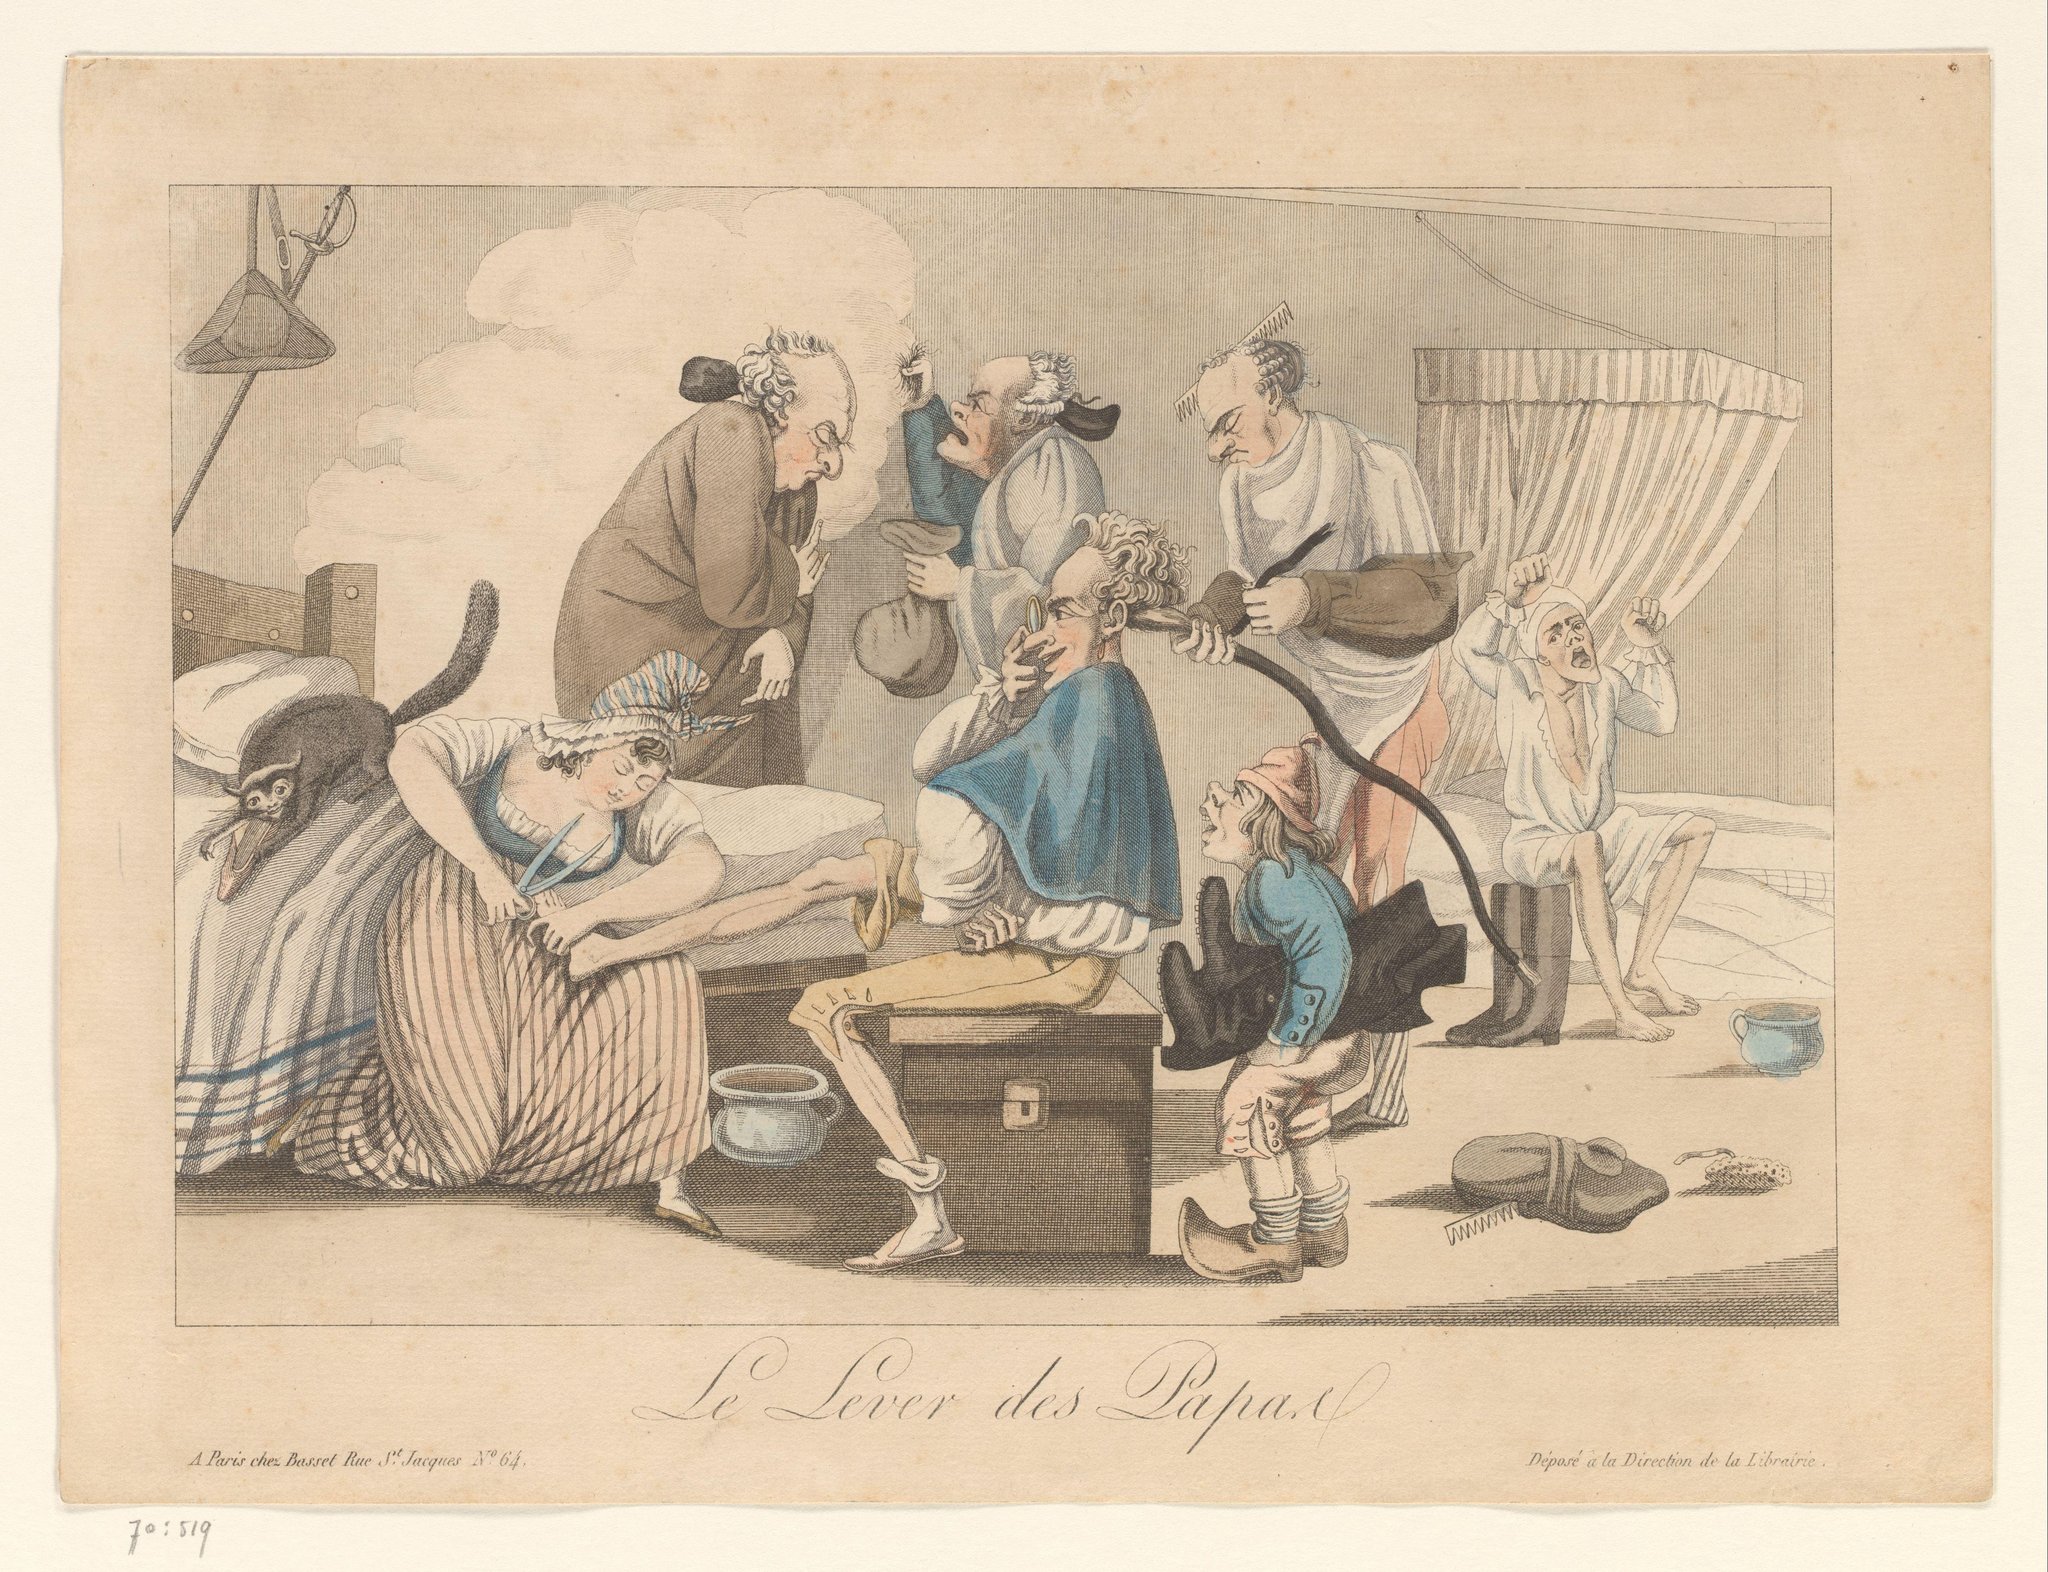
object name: cartoon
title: Le Lever des Papas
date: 1815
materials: paper, watercolor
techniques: etching, hand coloring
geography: paris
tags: pedicure, dressing oneself, getting dressed, hairdresser, wig, getting up from bed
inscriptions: collector's mark: ‘L. A. DE VRIES’, collector's mark: Lugt 2228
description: Ochtendrituelen: een aantal oudere mannen wordt klaargemaakt voor de dag. Een jonge vrouw knipt teennagels van de centrale zittende figuur, wiens lange vlecht ook wordt verzorgd. Een andere man bestuift een pruik met krijtpoeder. Een jonge knecht staat klaar met een paar laarzen.